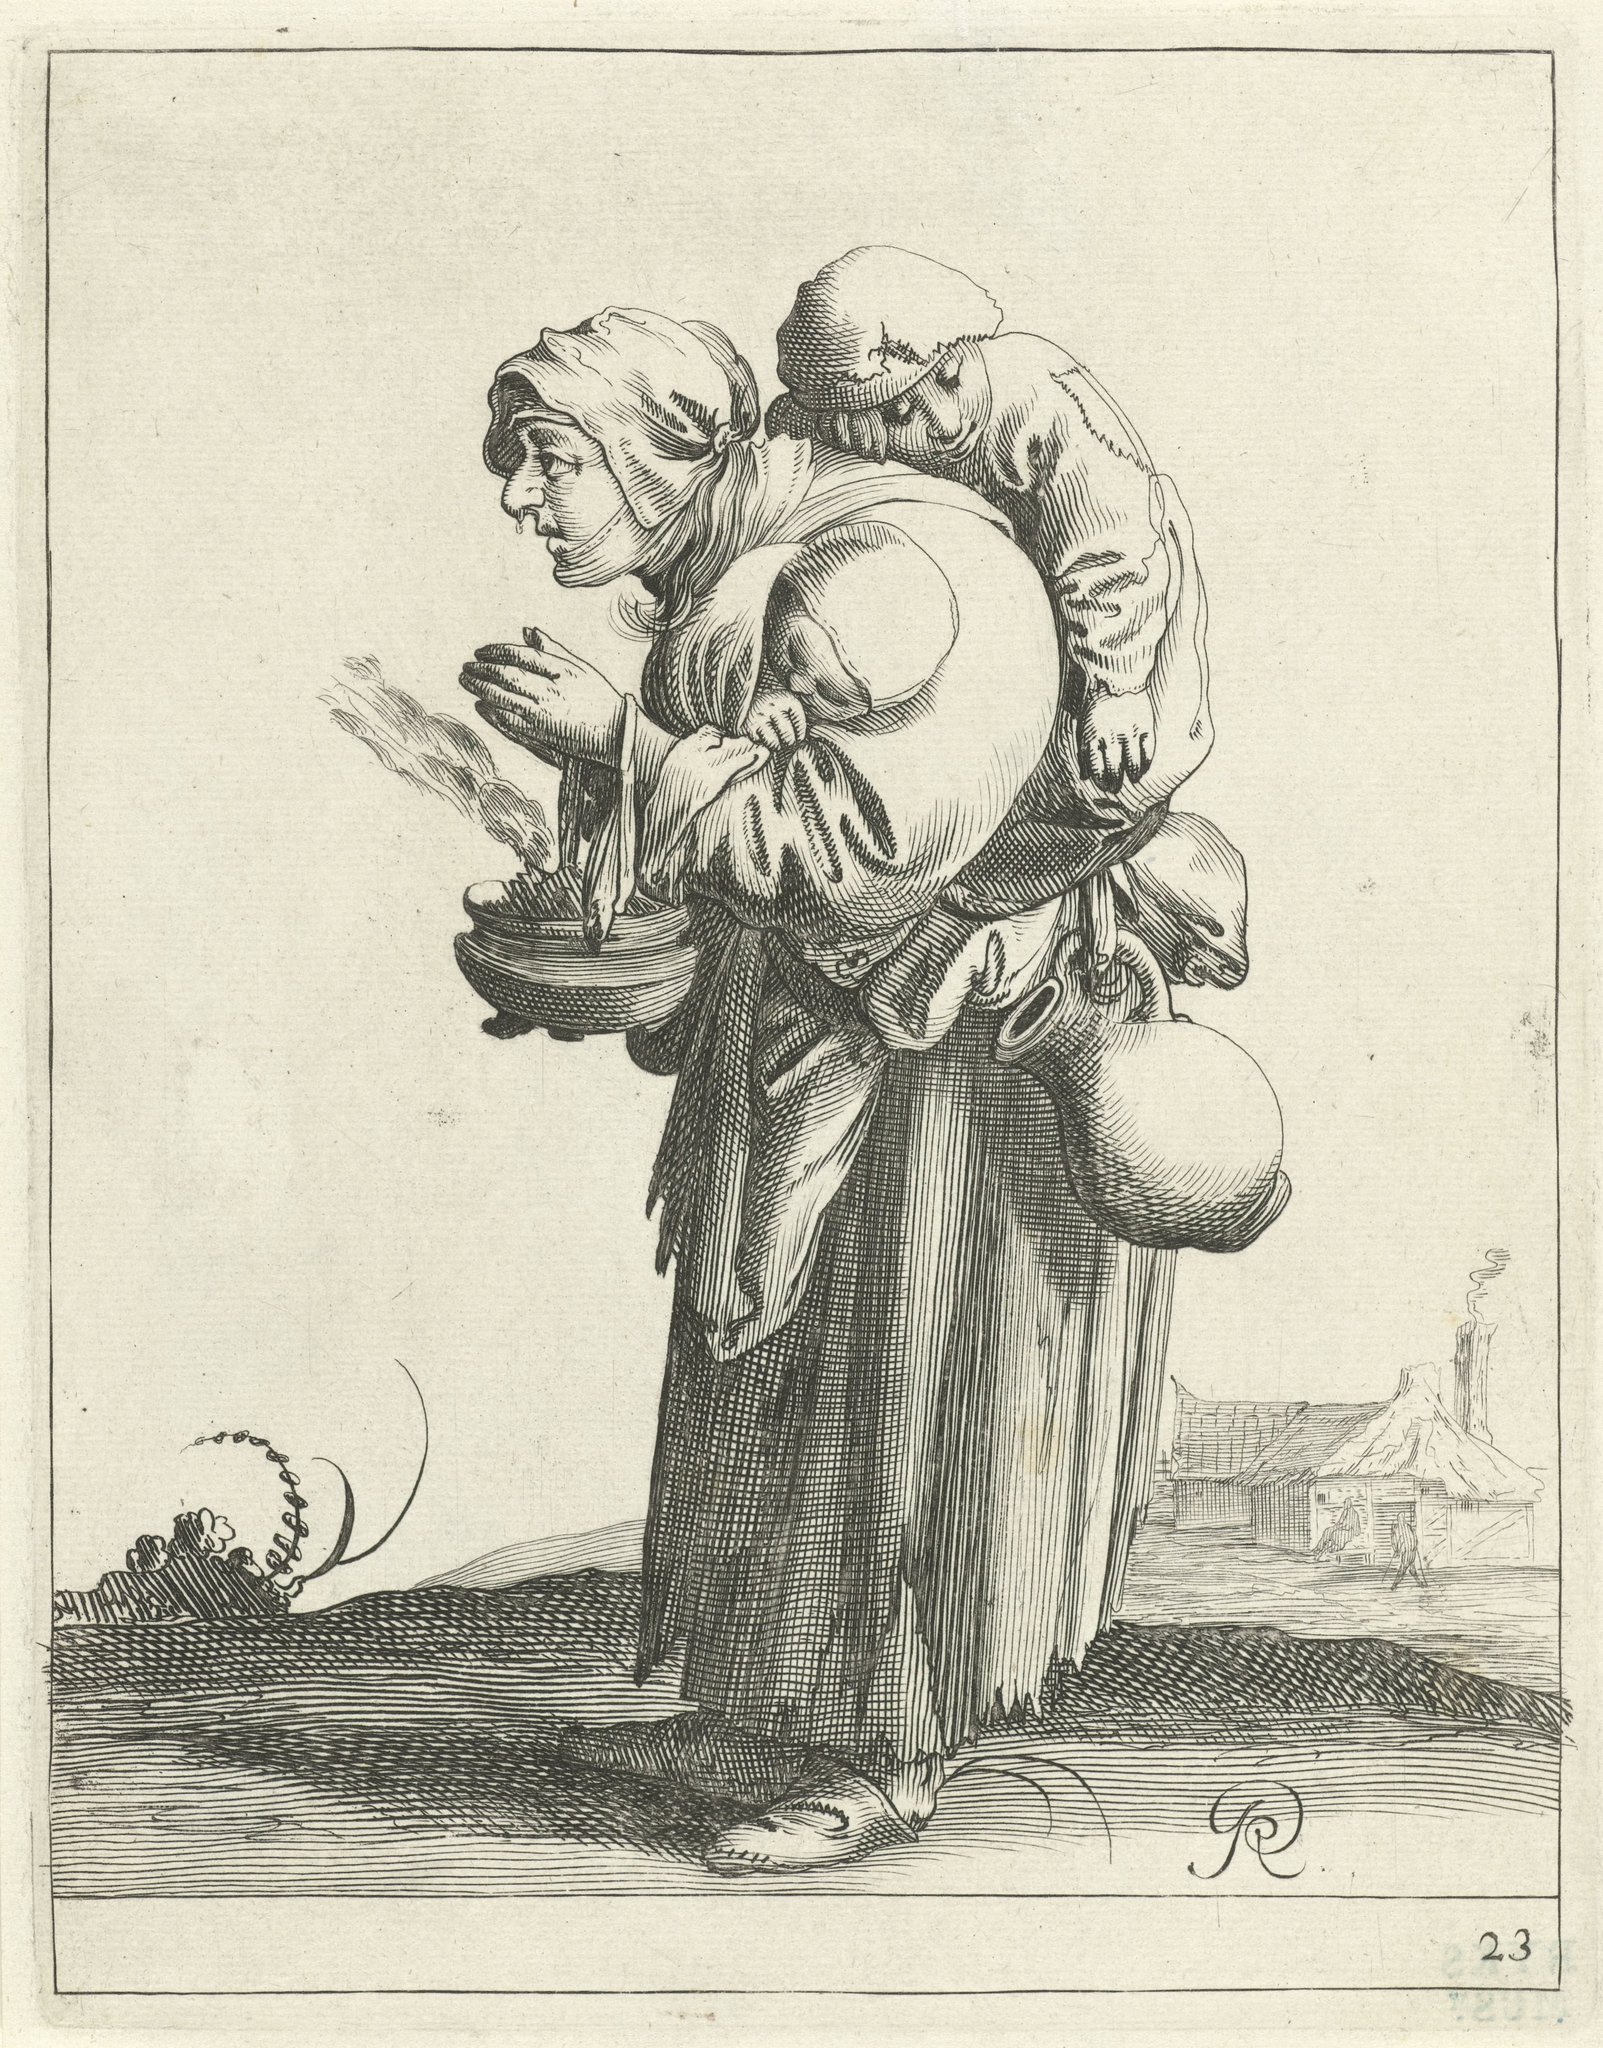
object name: print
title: Bedelaarster met kinderen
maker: pieter jansz quast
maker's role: draughtsman, painter, print maker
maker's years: 1605-1647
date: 1634-1638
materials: paper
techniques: engraving, etching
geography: the hague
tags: child, jar, jug (used as drinking-vessel), beggar, farm or solitary house in landscape, heating stove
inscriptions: collector's mark: Lugt 2165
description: Een zwerfster draagt een slapend kind op haar rug en een kind op haar borst. Ze warmt haar handen aan een pot met smeulende kolen. De prent maakt deel uit van een serie van zesentwintig prenten met bedelaars en boeren.